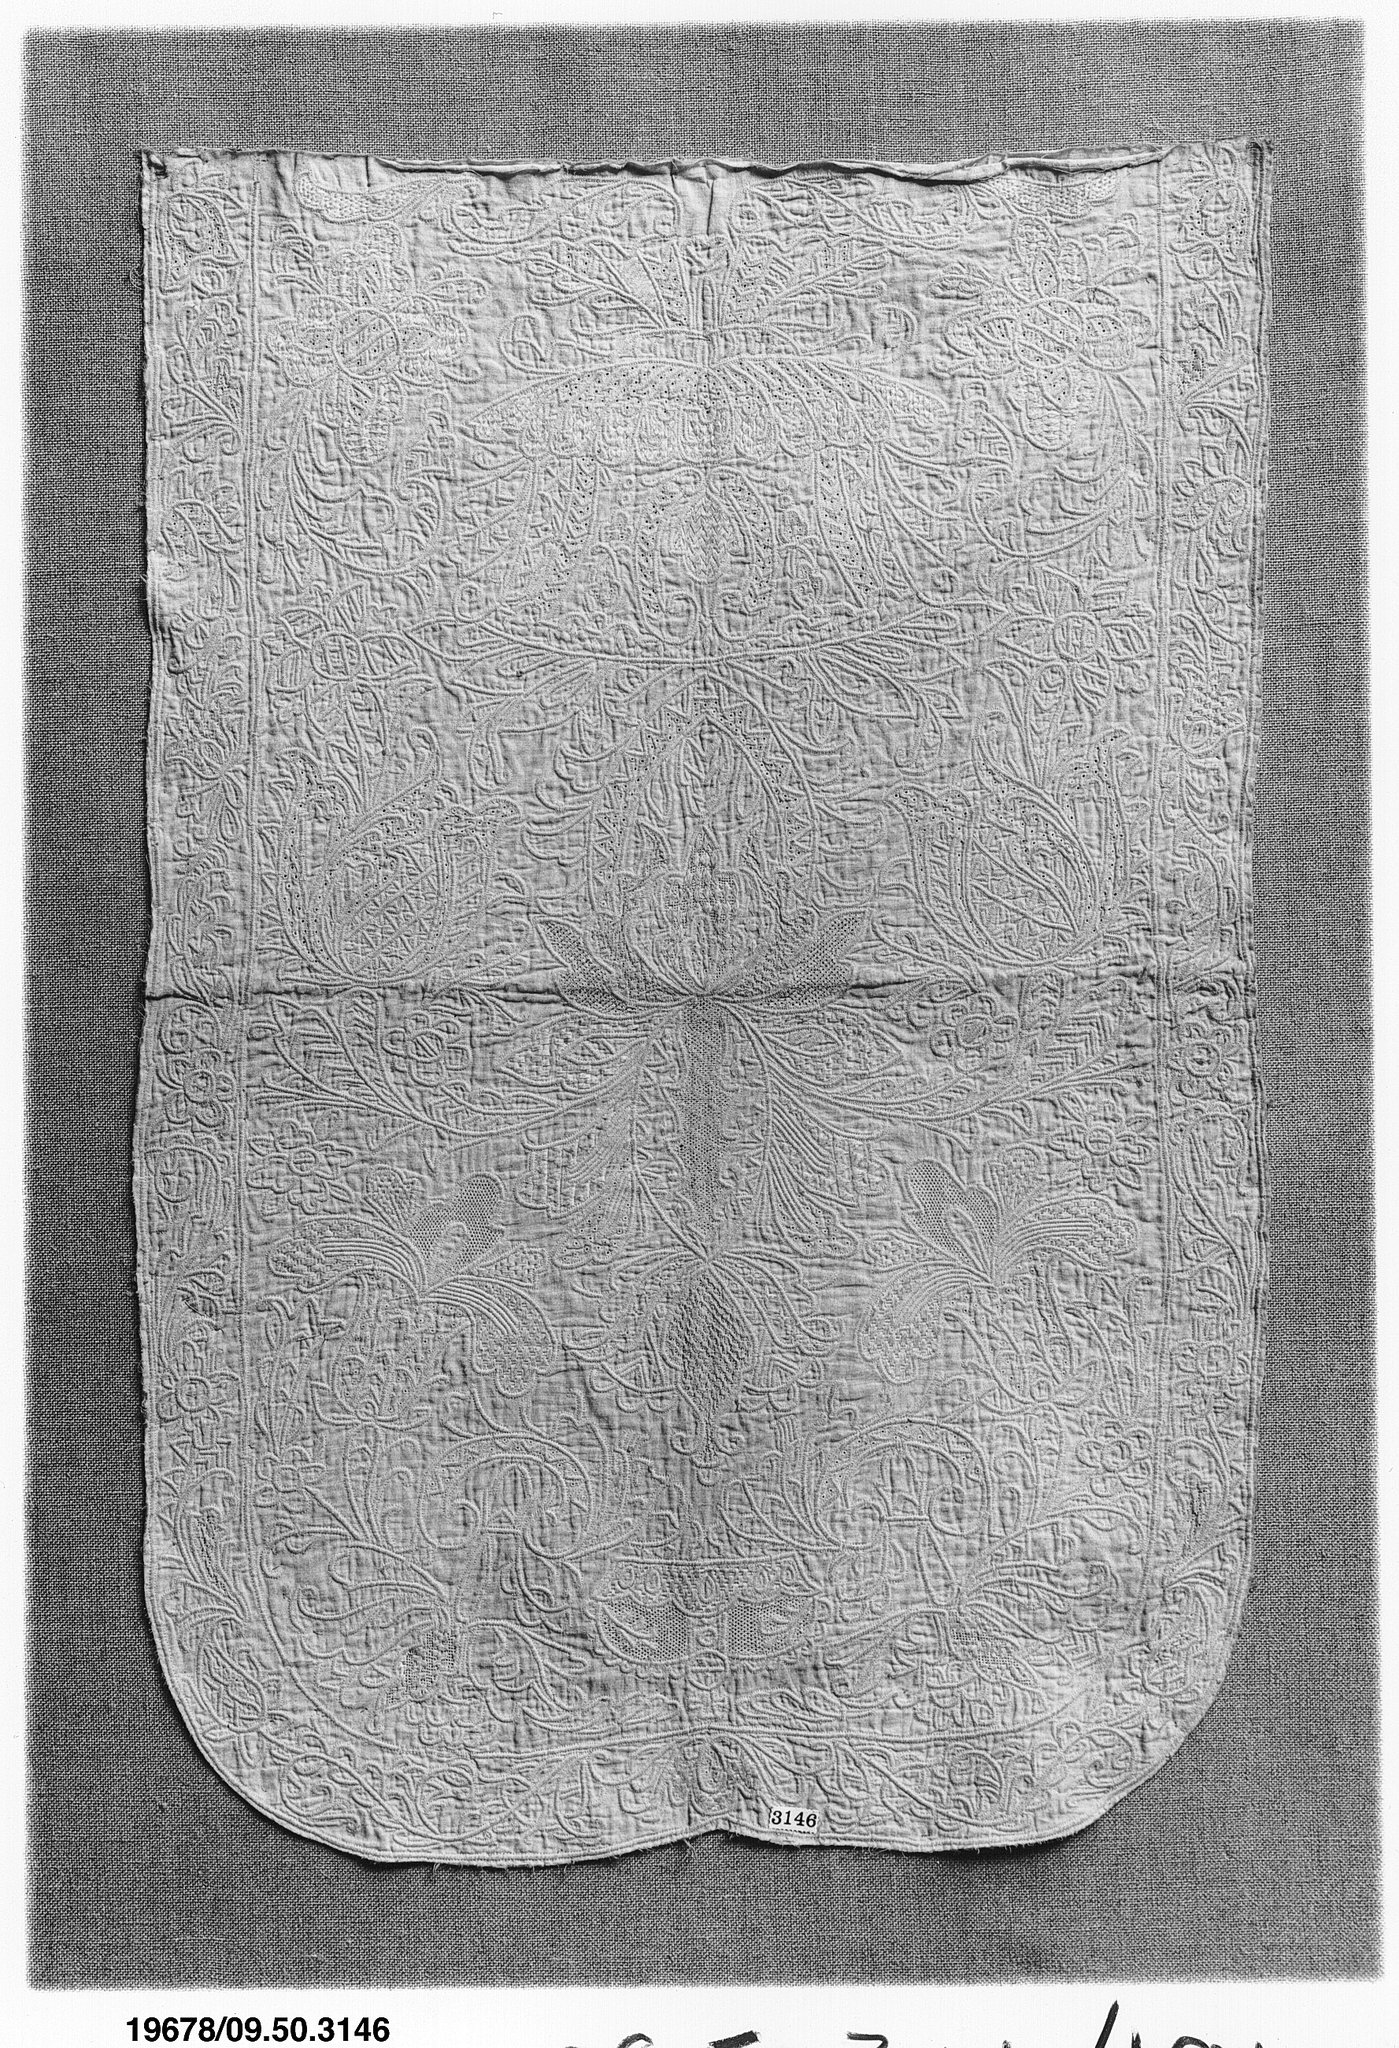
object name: panel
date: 1701-1800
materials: cotton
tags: flowers,leaves